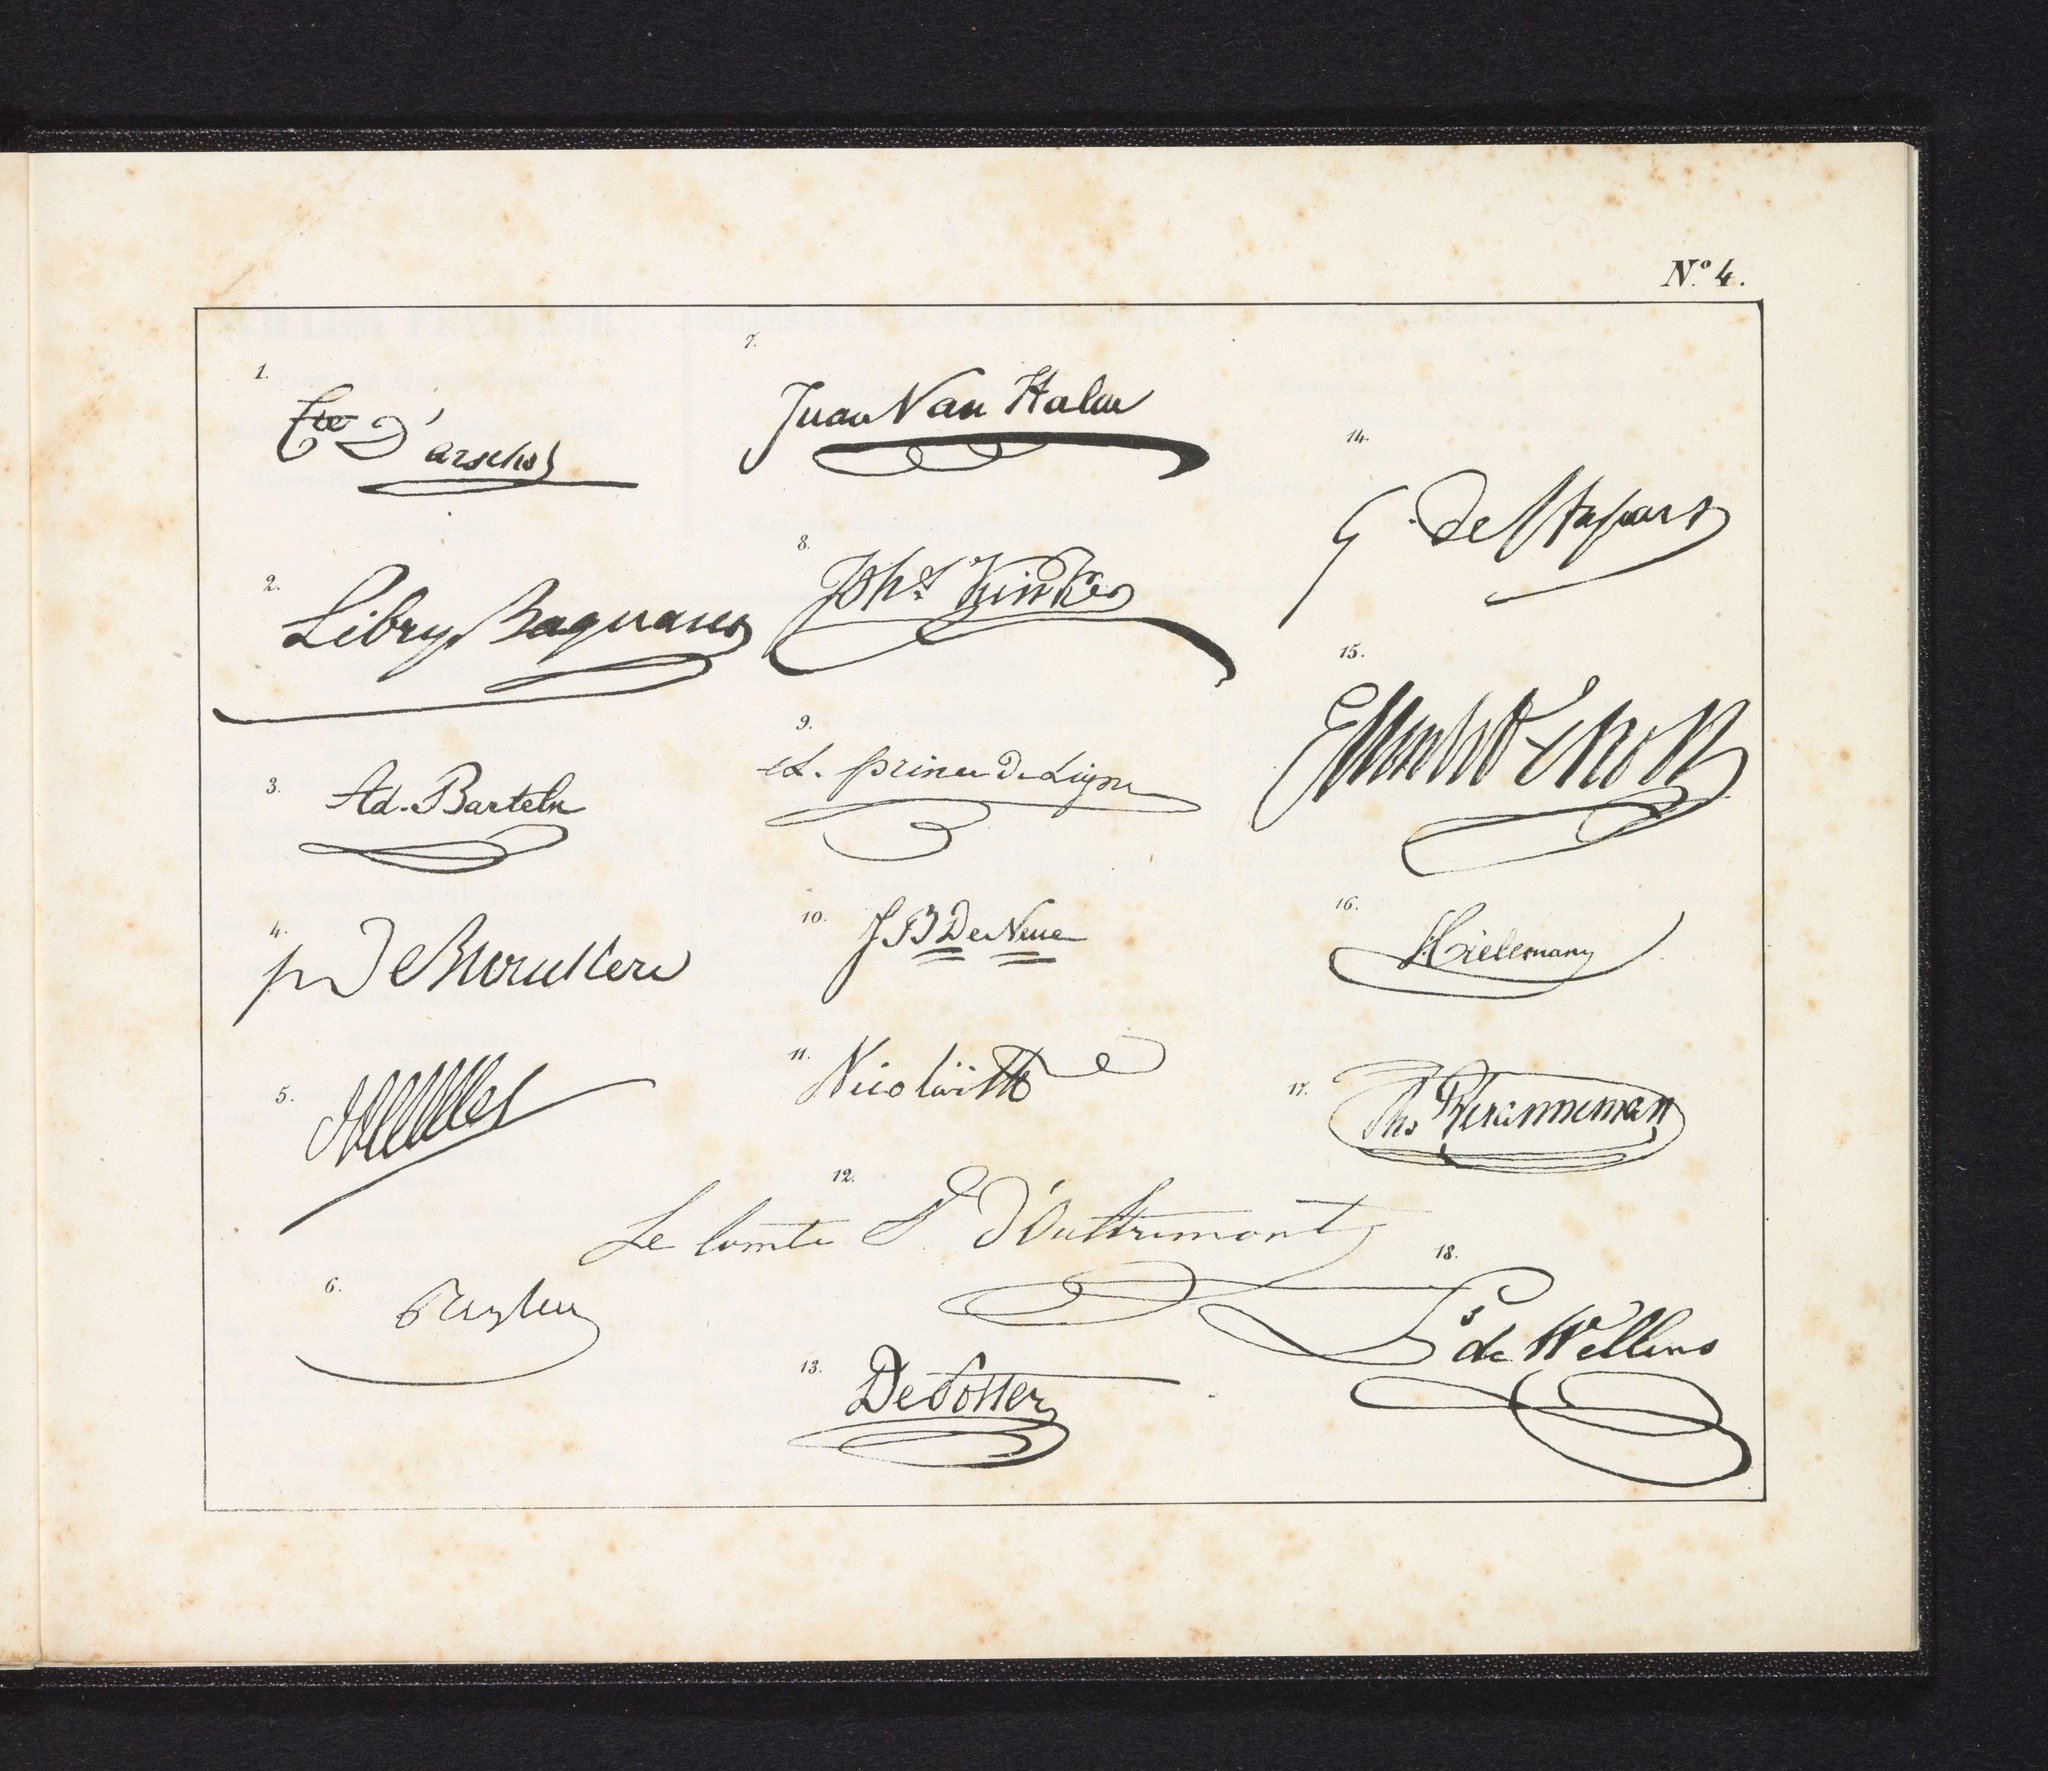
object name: print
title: Handtekeningen van Belgen, 1830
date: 1830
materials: paper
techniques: lithograph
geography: netherlands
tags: handwriting, written text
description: Facsimiles van de handtekeningen van achttien Belgische betrokkenen. Illustratie in een bundel van twee cahiers met facsimiles van de handtekeningen van hoofdrolspelers in de Belgische Revolutie in 1830.